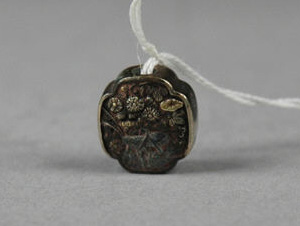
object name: ojime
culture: japanese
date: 1801-1900